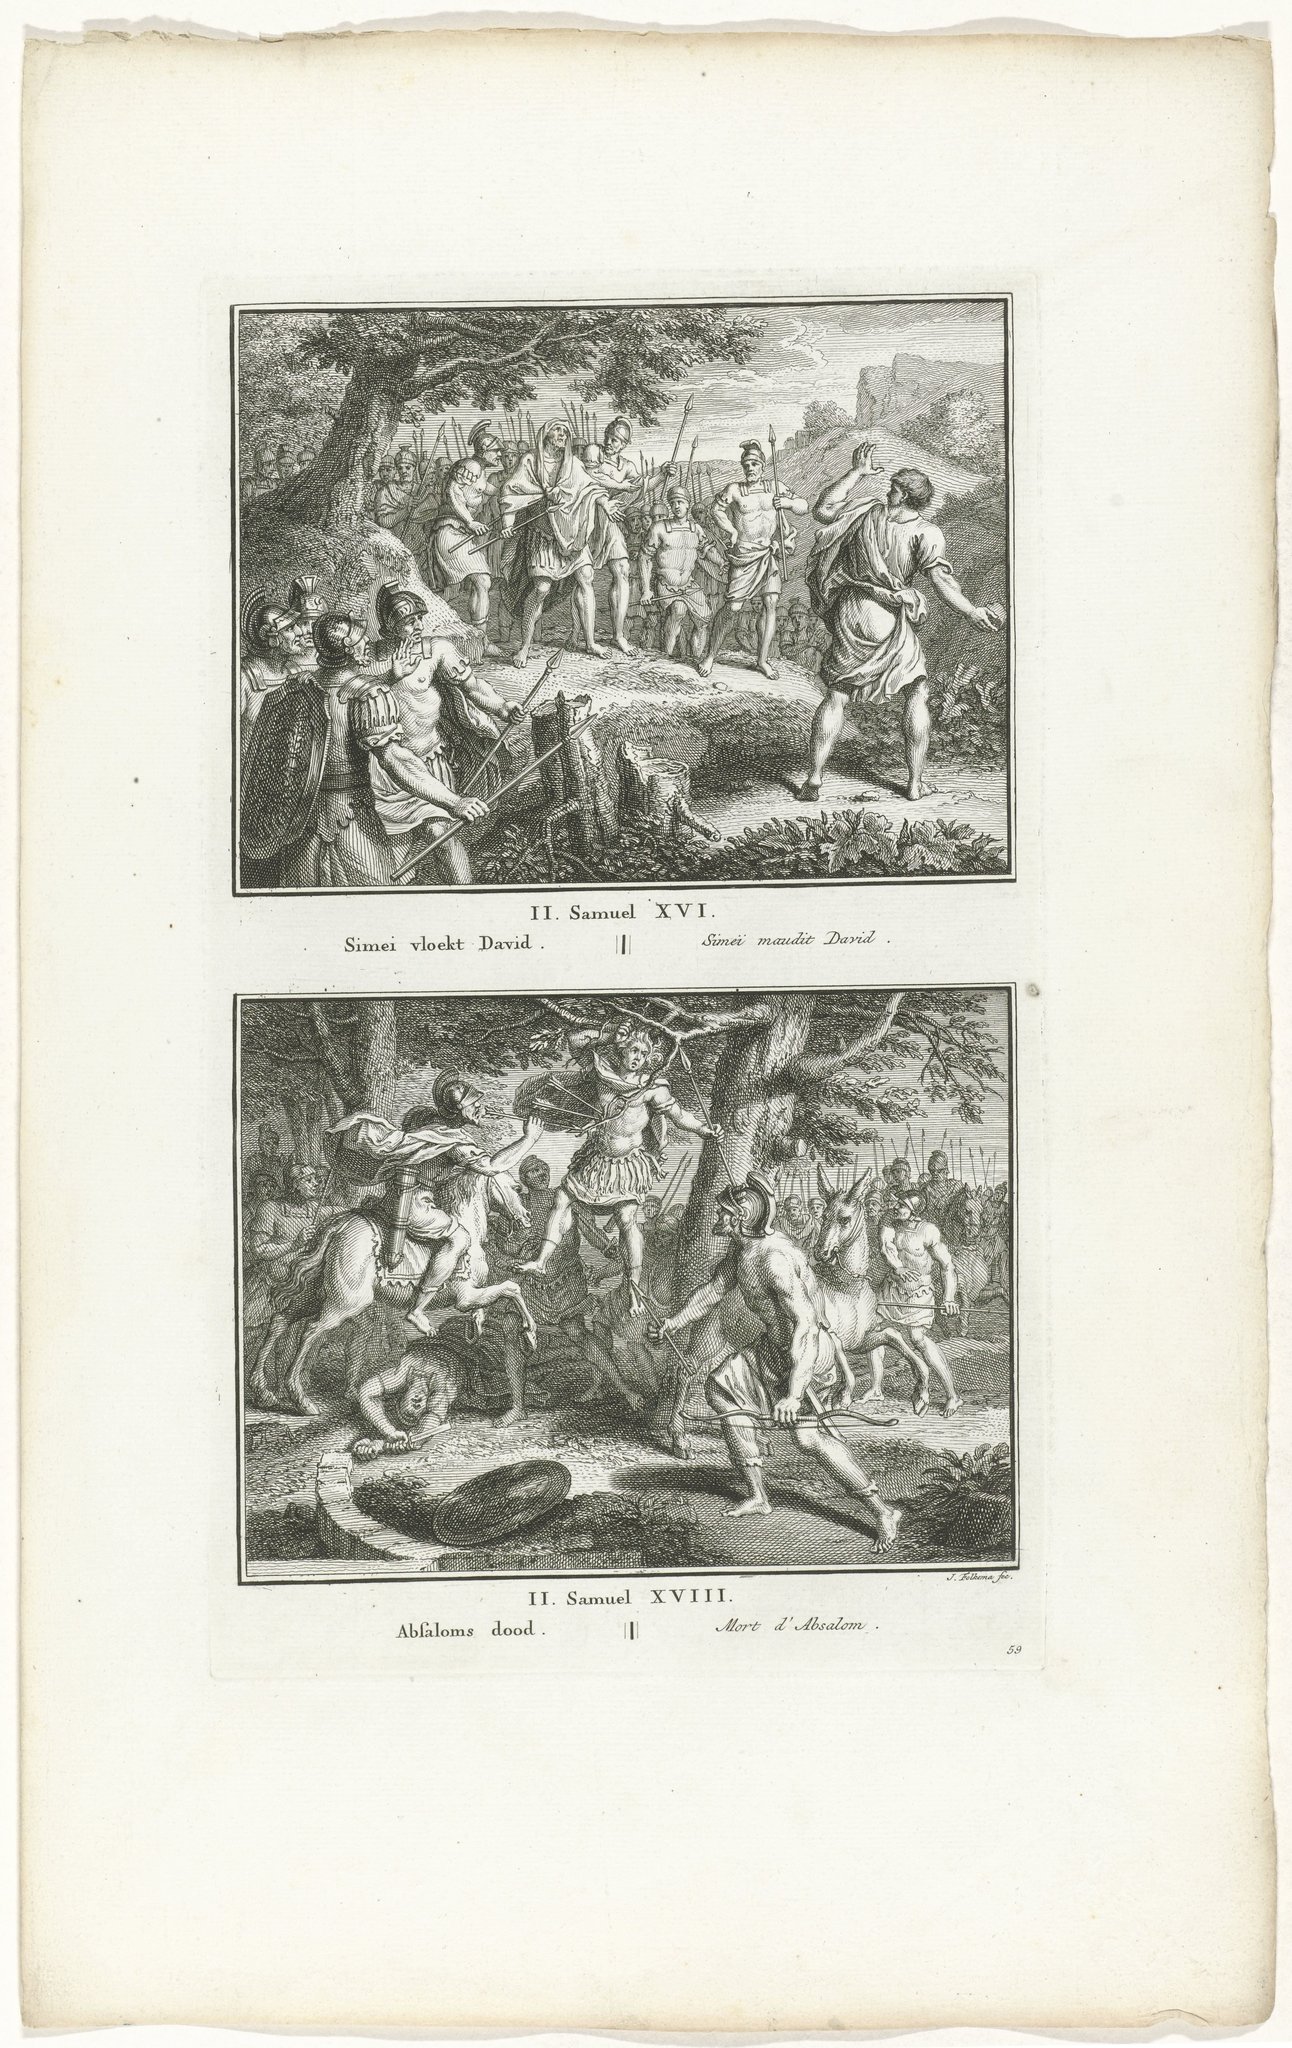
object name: print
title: Simei vervloekt David en de dood van Absalom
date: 1791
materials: paper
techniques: etching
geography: dordrecht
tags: shimei curses david and casts stones at him, absalom, put to flight on a mule, remains hanging by his hair in an oak-tree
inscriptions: collector's mark, collector's mark: Lugt 2233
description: Twee Bijbelse voorstellingen uit 2 Sam. 16 en 18. Simei vervloekt David en gooit stenen naar hem, en Absalom blijft met zijn haren hangen aan een eik en wordt gedood. Twee voorstellingen van één plaat, elk voorzien van een titel in het Nederlands en Frans. Geheel rechtsonder genummerd: 59.